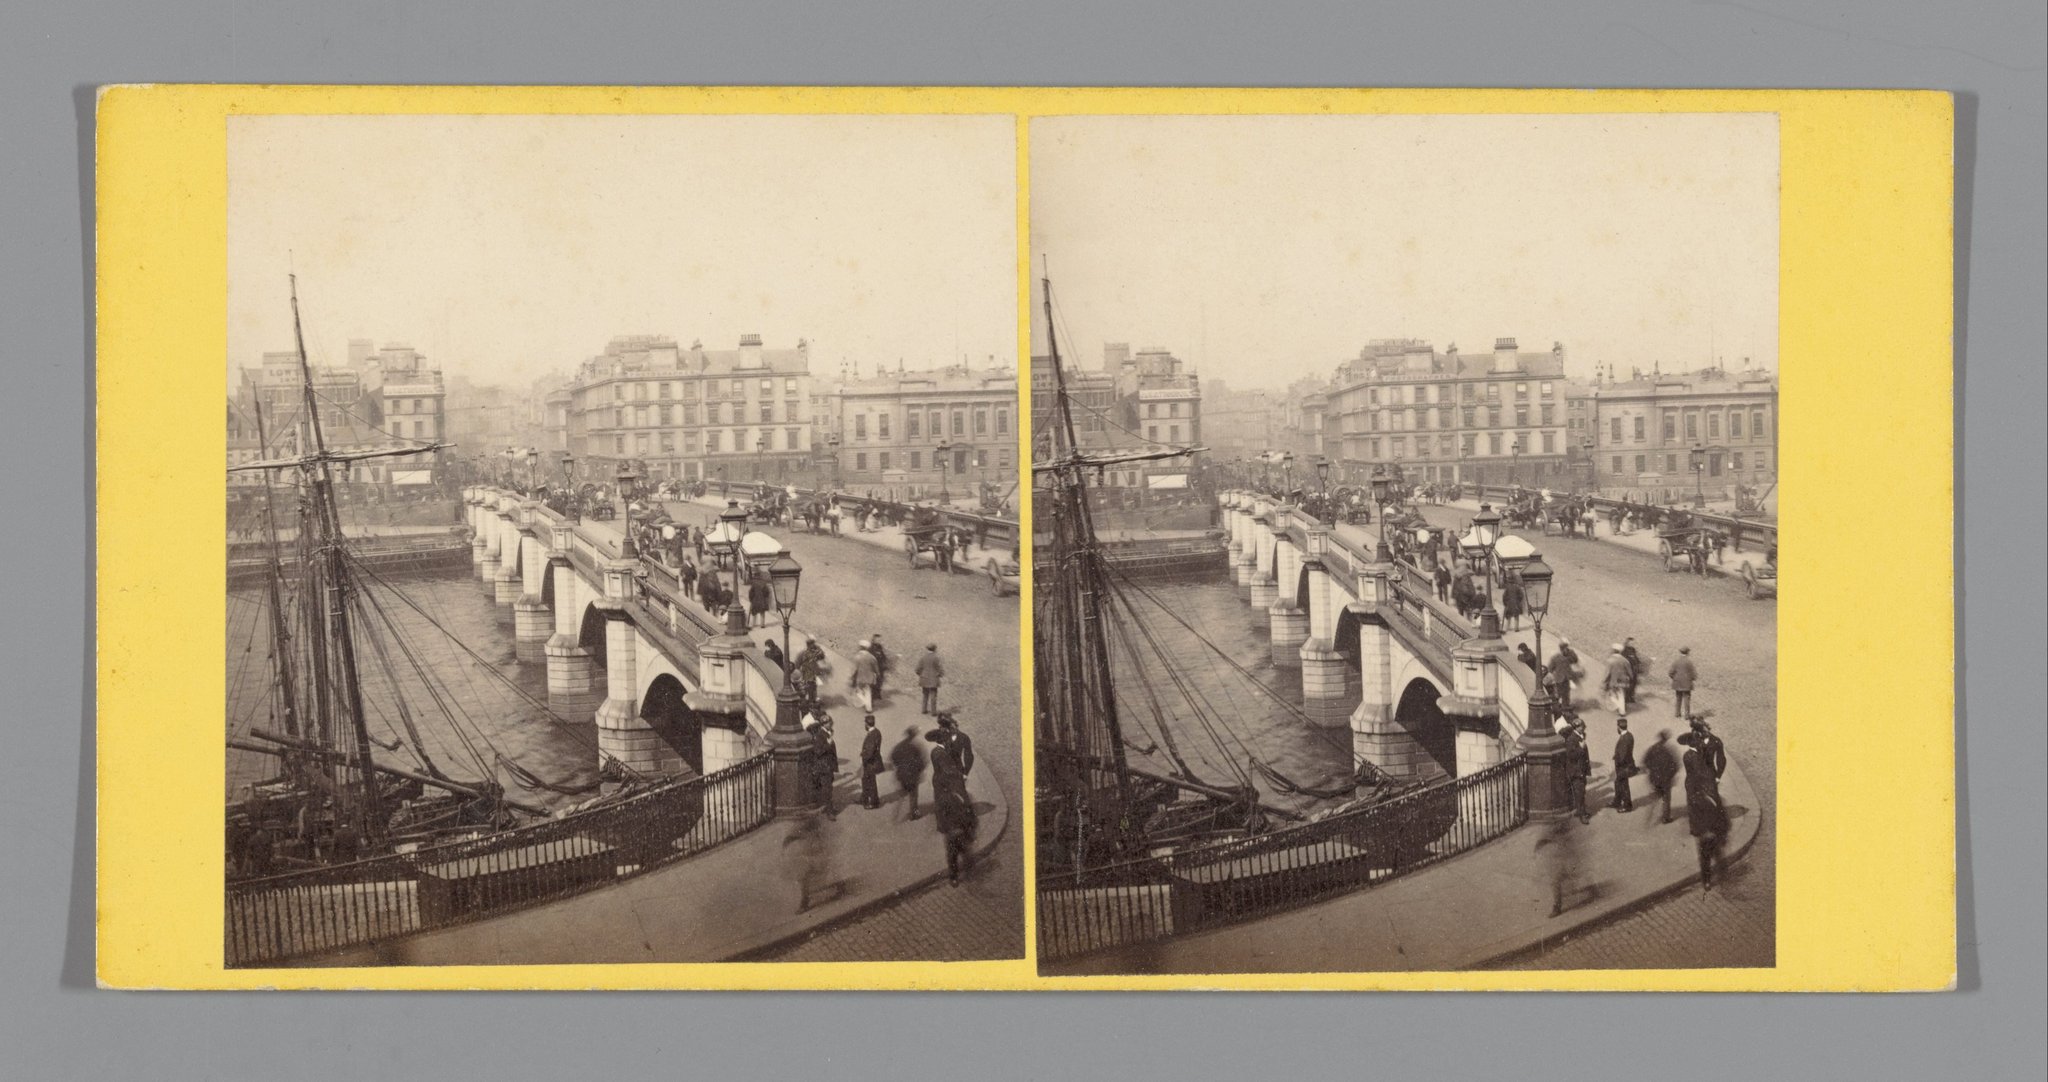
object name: stereograph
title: Glasgow Bridge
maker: george washington wilson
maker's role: publisher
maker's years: 1823-1893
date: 1850-1880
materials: cardboard, photographic support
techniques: albumen print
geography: glasgow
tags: bridge, glasgow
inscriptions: number: ‘No. 43.’, name: ‘Registered G. W. Wilson, Photographer, Aberdeen’